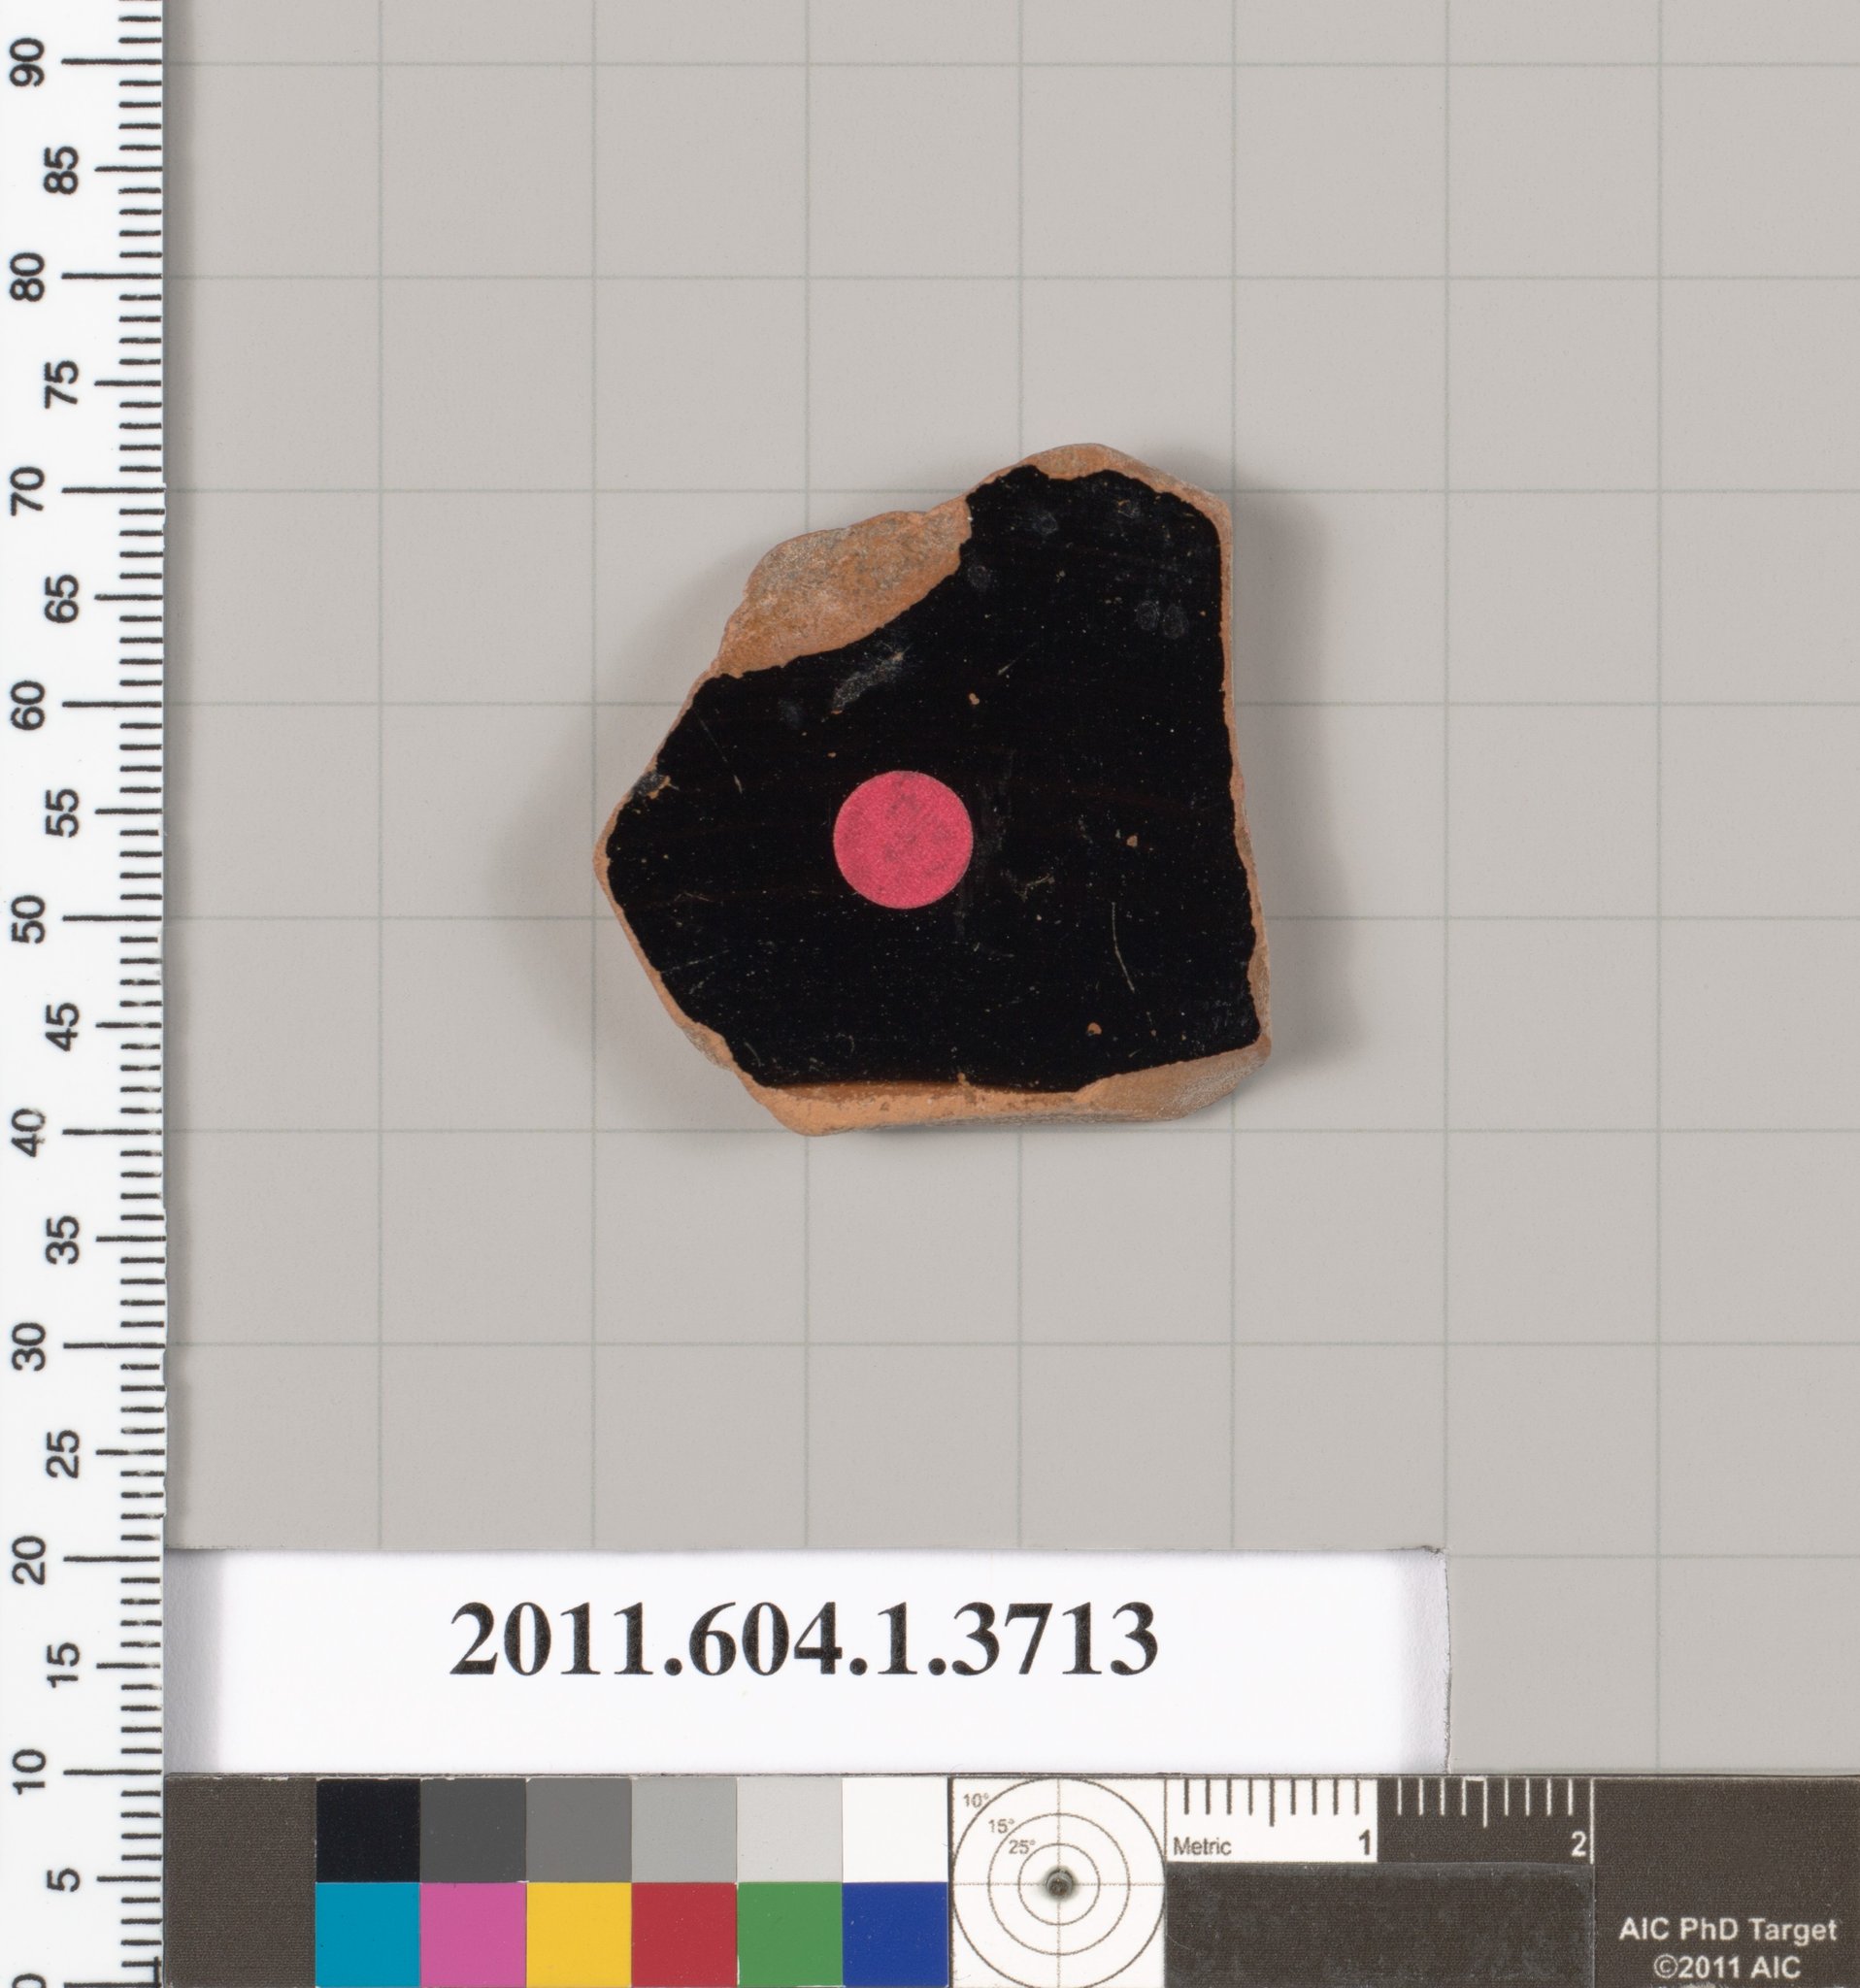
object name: kylix fragment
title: Terracotta fragment of a kylix (drinking cup)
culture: greek, attic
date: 490-470 BCE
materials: terracotta